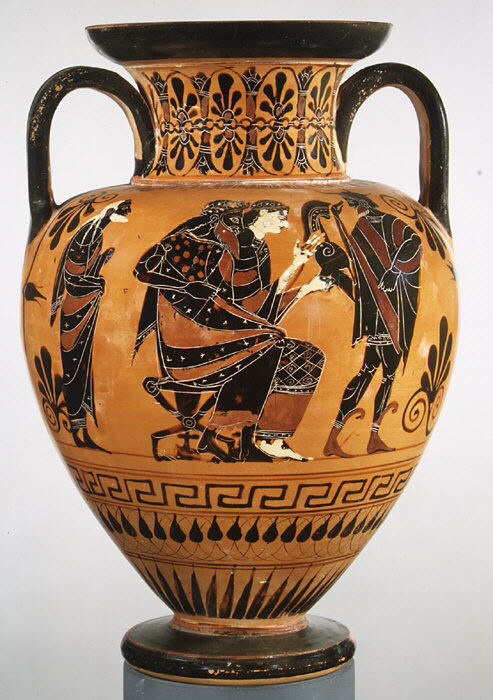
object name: neck amphora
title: Terracotta neck-amphora (jar)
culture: greek, attic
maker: lysippides painter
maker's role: artist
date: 520 BCE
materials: terracotta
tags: helmets,men,dionysus,horses,chariots